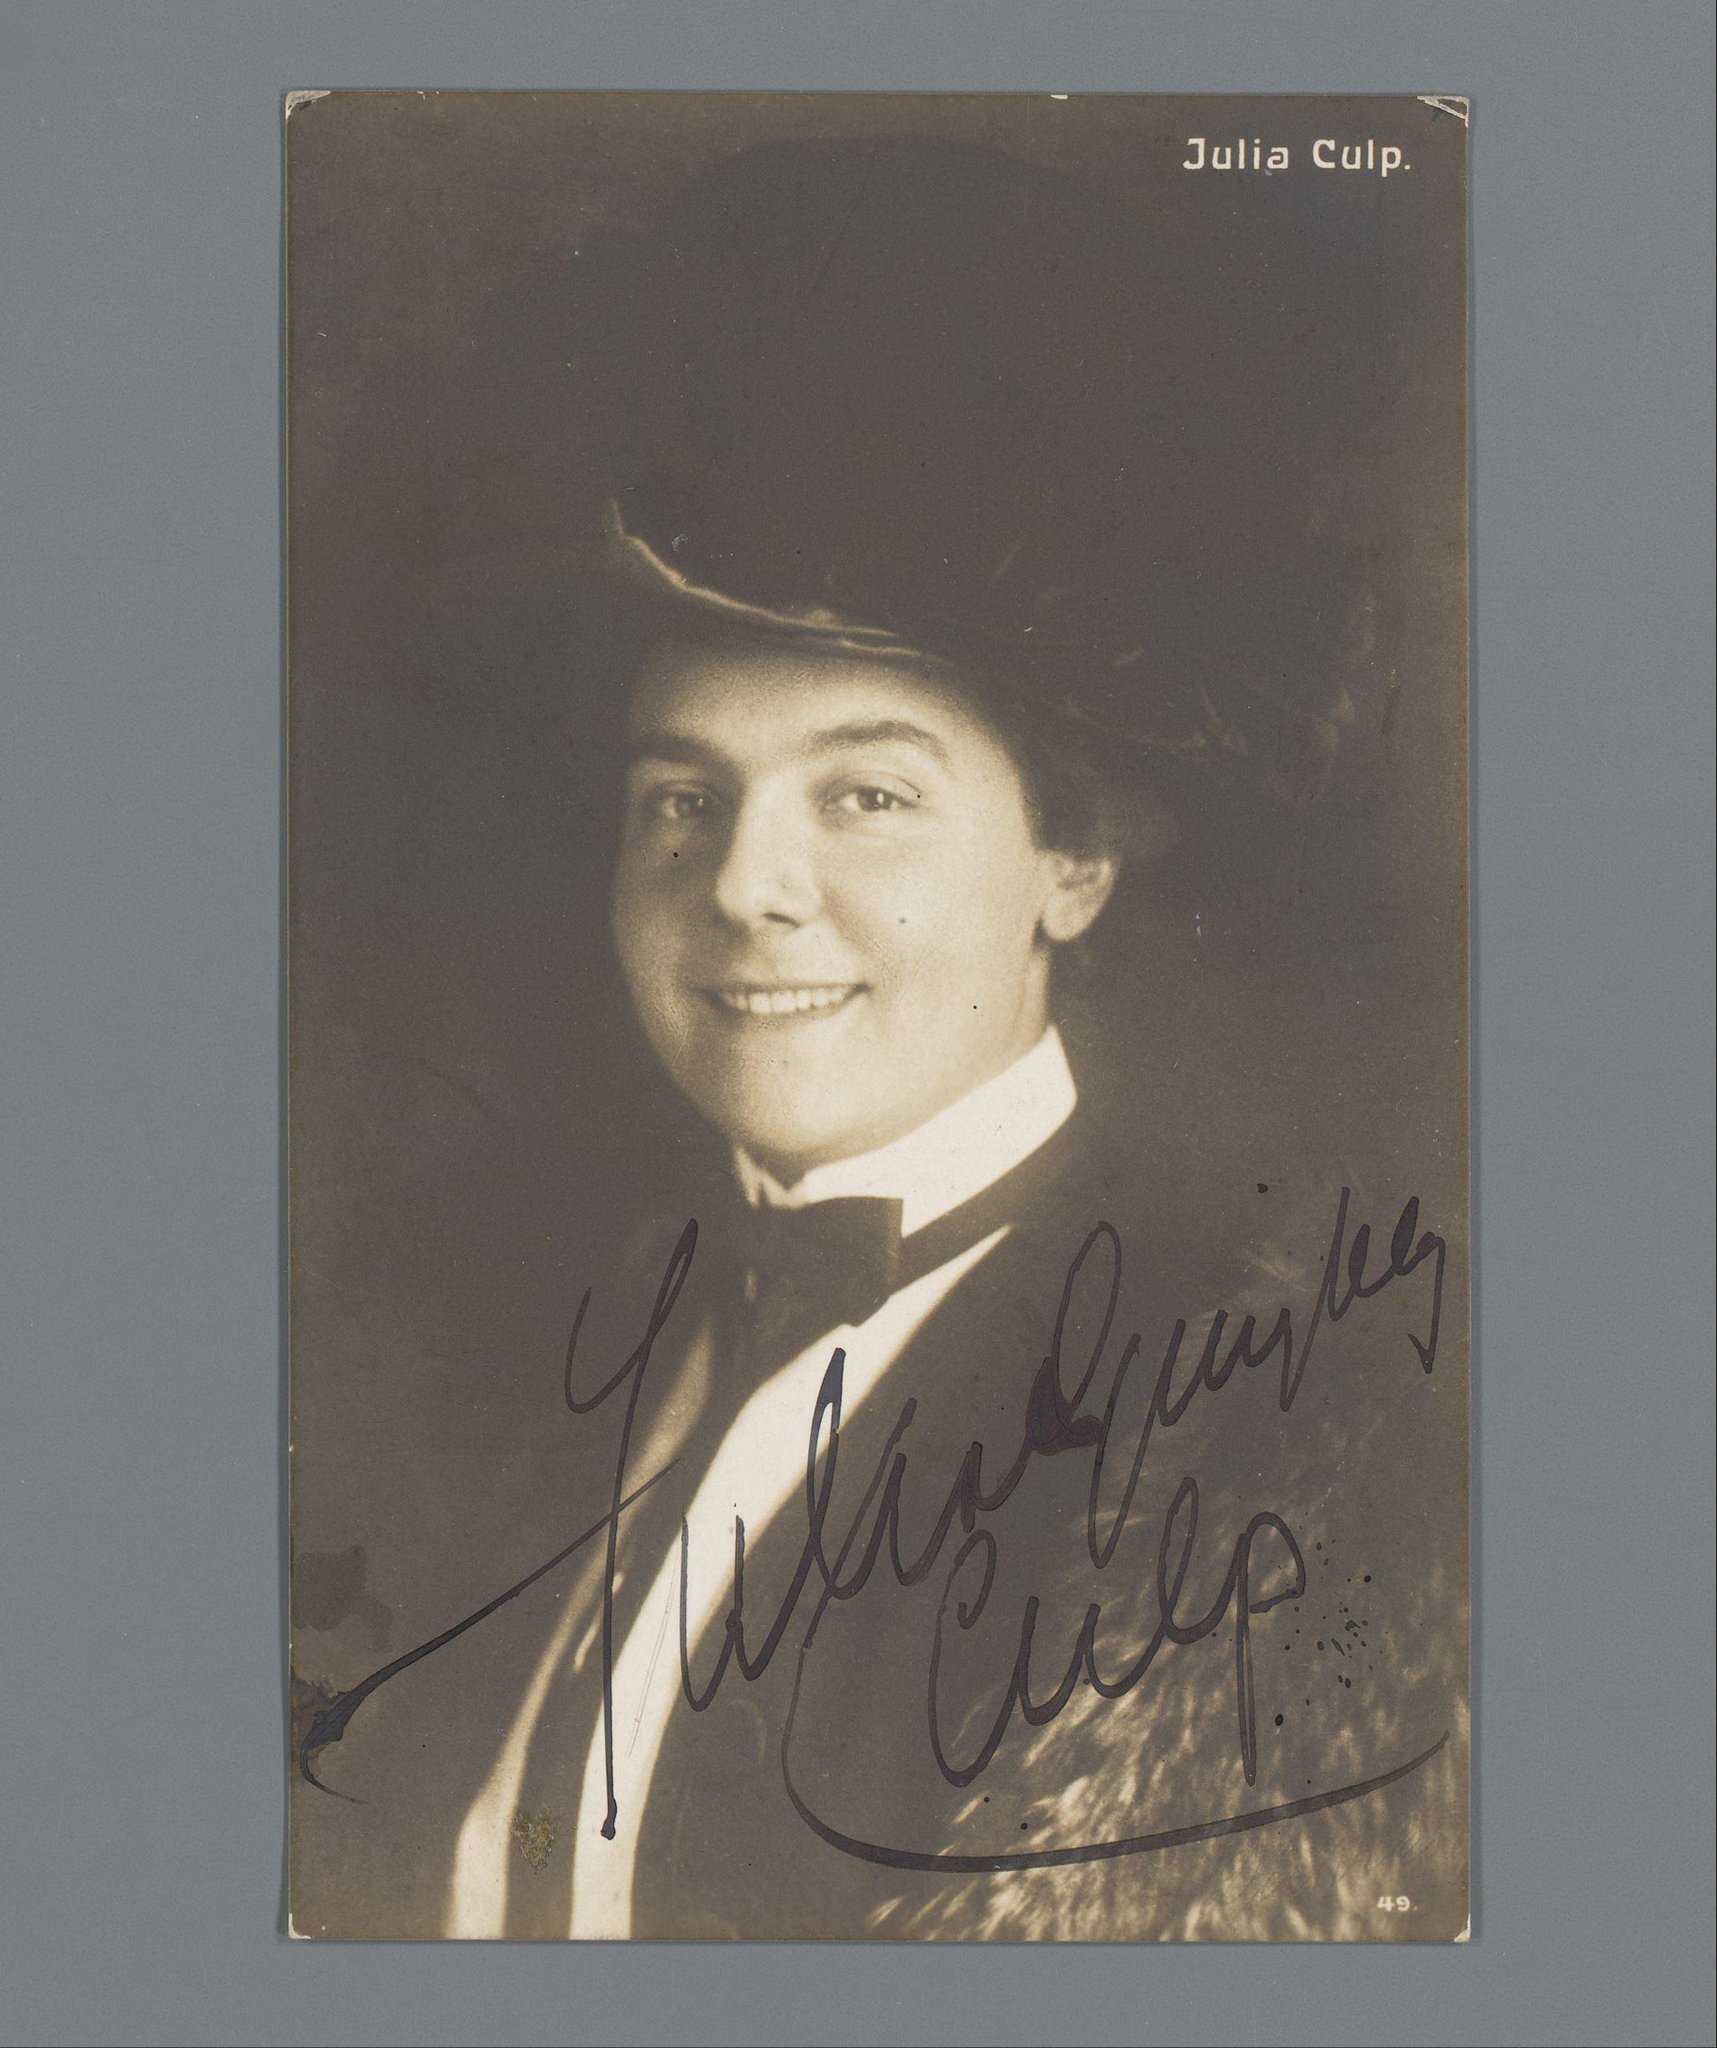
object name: ansichtkaart, prentbriefkaart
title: Portret van de mezzosopraan Julia Culp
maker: Anonymous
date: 1900-1920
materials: paper, cardboard, ink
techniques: gelatin silver print, pen, typewriting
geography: berlin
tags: historical persons, female singer, netherlands, berlin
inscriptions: inscription: ‘Amice, Dank voor je kaart. (...)’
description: Gesigneerd. Op de achterzijde een korte getypte tekst gericht aan Nico Meijer, geschreven door een kennis van hem.